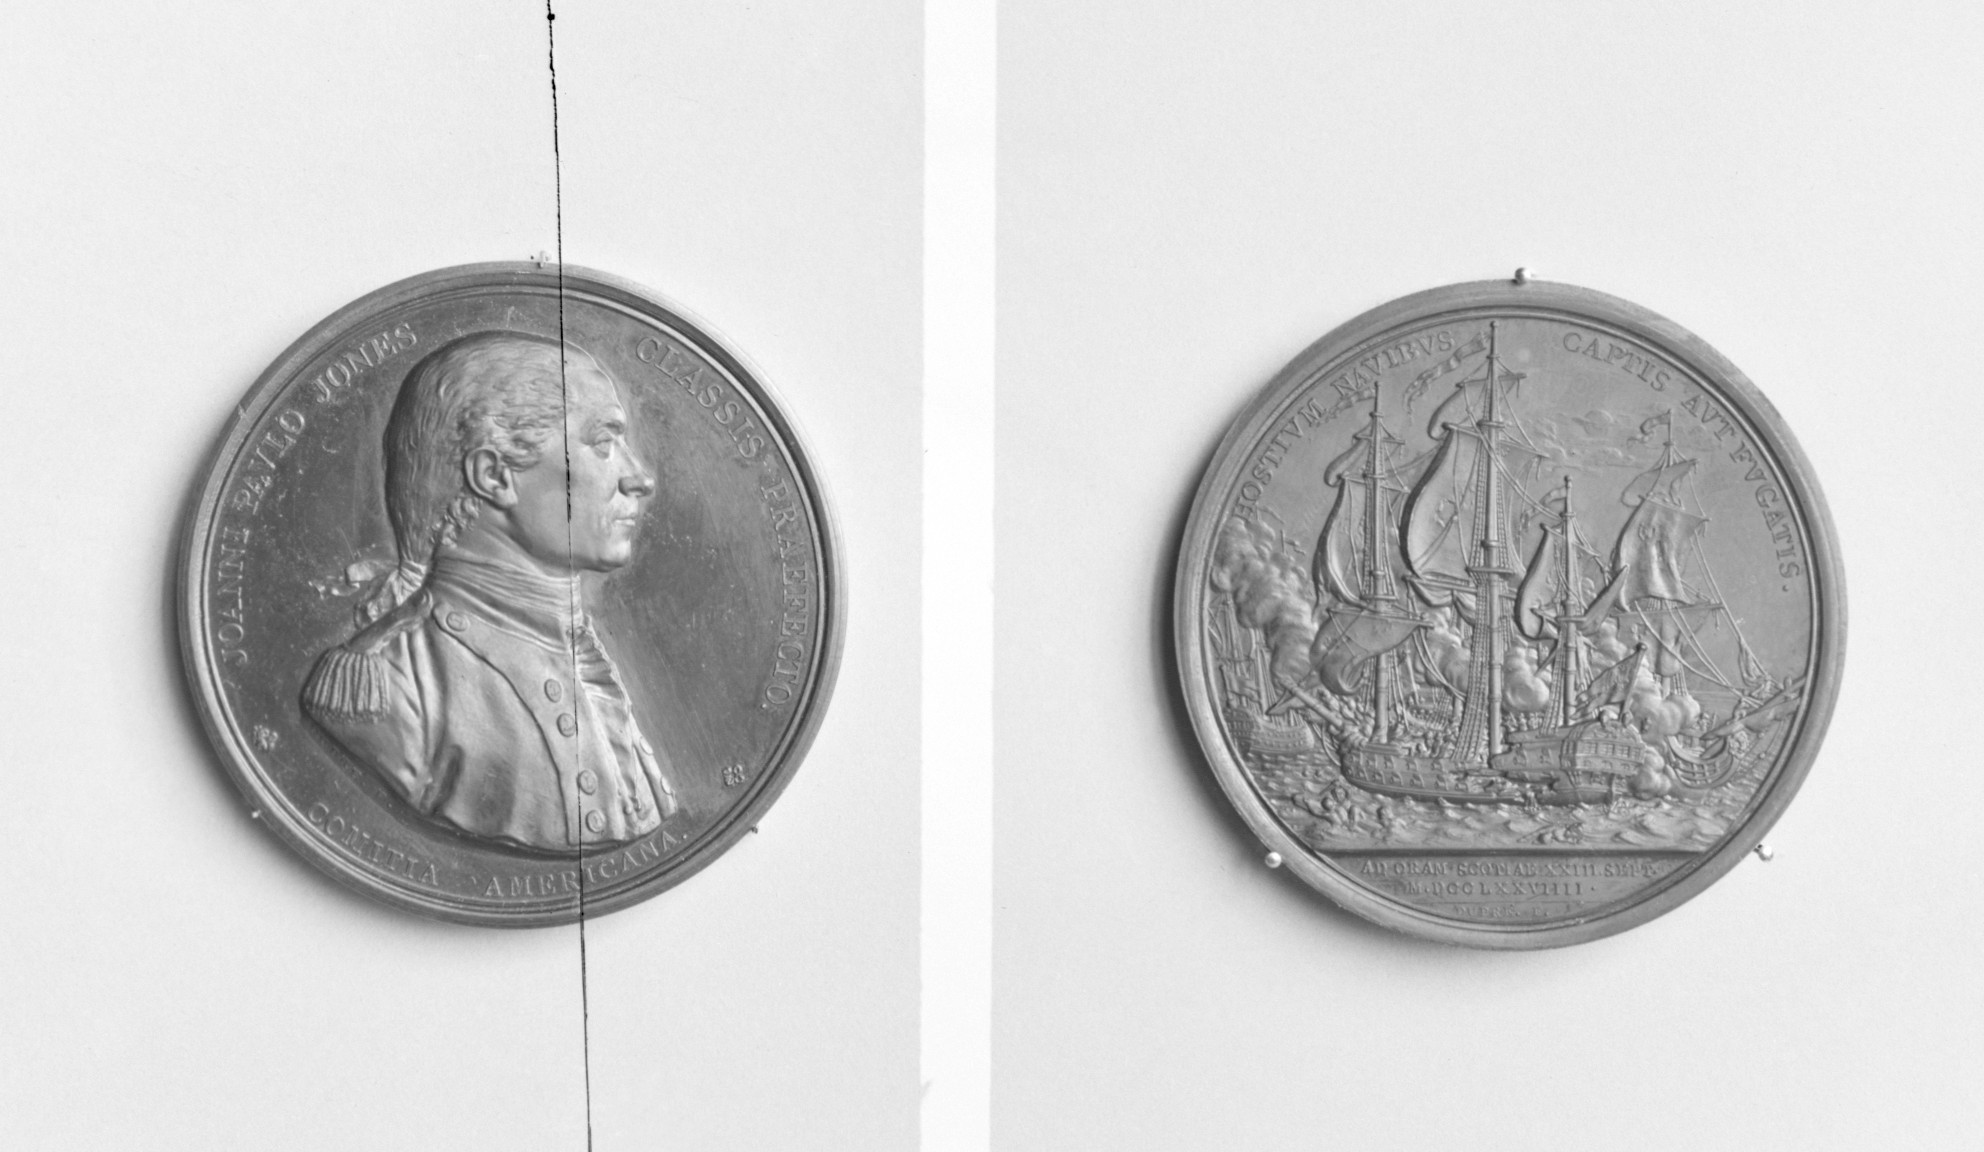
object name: medal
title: The Engagement of John Paul (Jones) (1747–92) with the British ship Serapis off Flamborough Head, September 23, 1779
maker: augustin dupré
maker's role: artist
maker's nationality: french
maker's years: 1748-1833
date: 1779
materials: bronze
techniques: struck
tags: men,profiles,ships